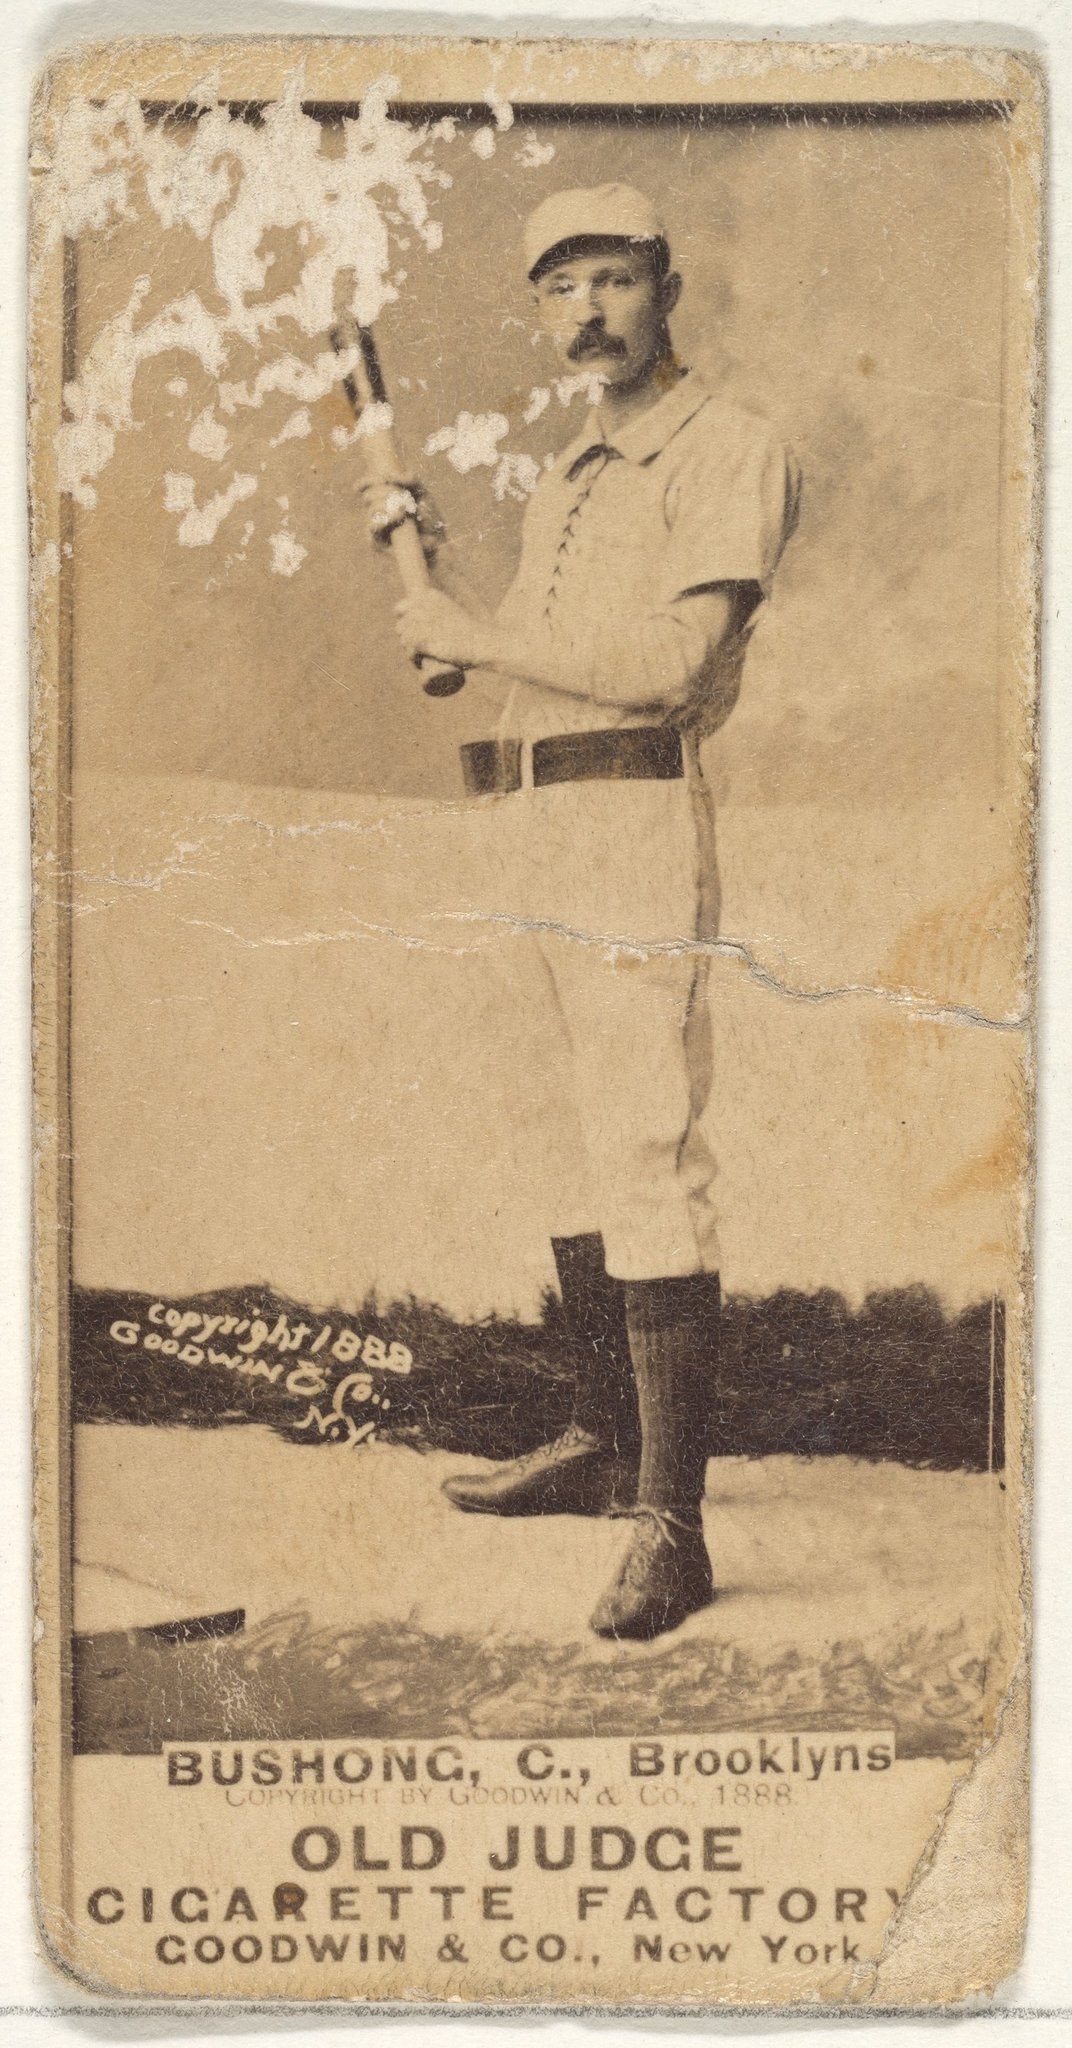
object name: baseball card, photograph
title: Bushong, Catcher, Brooklyn, from the Old Judge series (N172) for Old Judge Cigarettes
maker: goodwin & company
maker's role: publisher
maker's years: 1850-1950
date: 1888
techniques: albumen silver print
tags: men,portraits,baseball,athletes